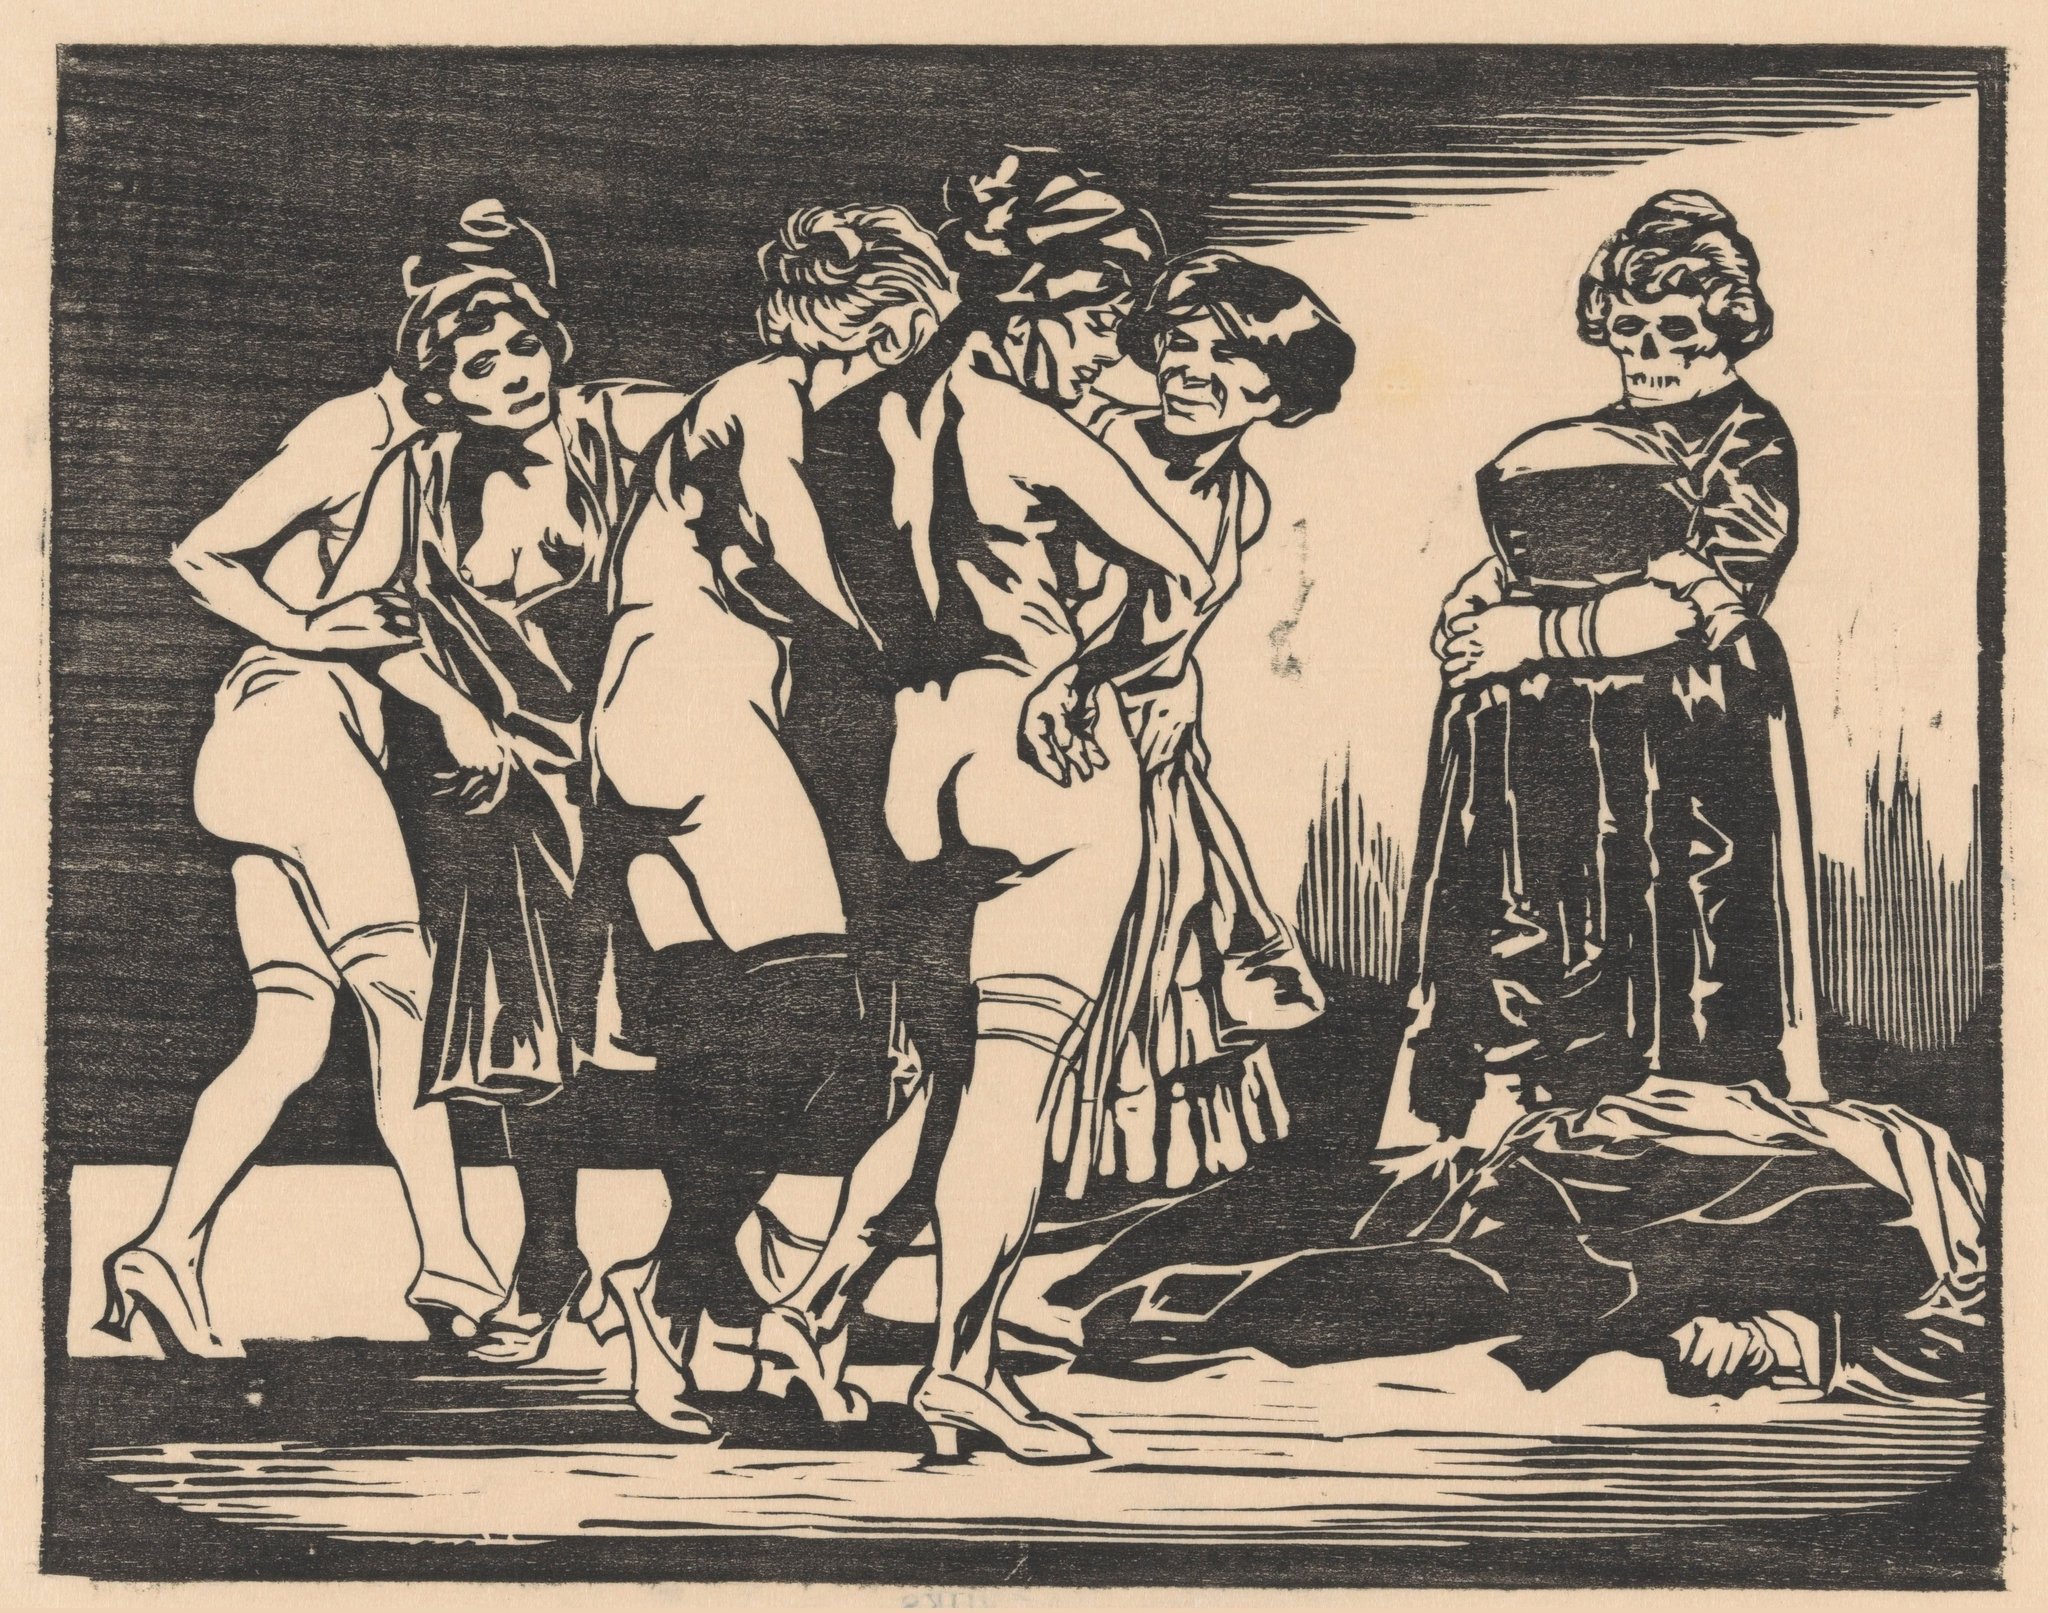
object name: print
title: Allegorie op de onkuisheid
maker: johannes josephus aarts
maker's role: draughtsman, print maker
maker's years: 1871-1934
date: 1881-1934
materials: paper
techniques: woodcut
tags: brothel, personifications of death; 'morte' (ripa) - ff - death as female, woman (showing herself) undressed, quasi-nude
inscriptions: collector's mark: Lugt 2166, collector's mark: Lugt 2760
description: Een groep vrouwen is gedeeltelijk gekleed en draagt schoenen met hoge hakken. Rechts van hen ligt het lichaam van een man. Achter de man staat de Dood, gekleed in een jurk.